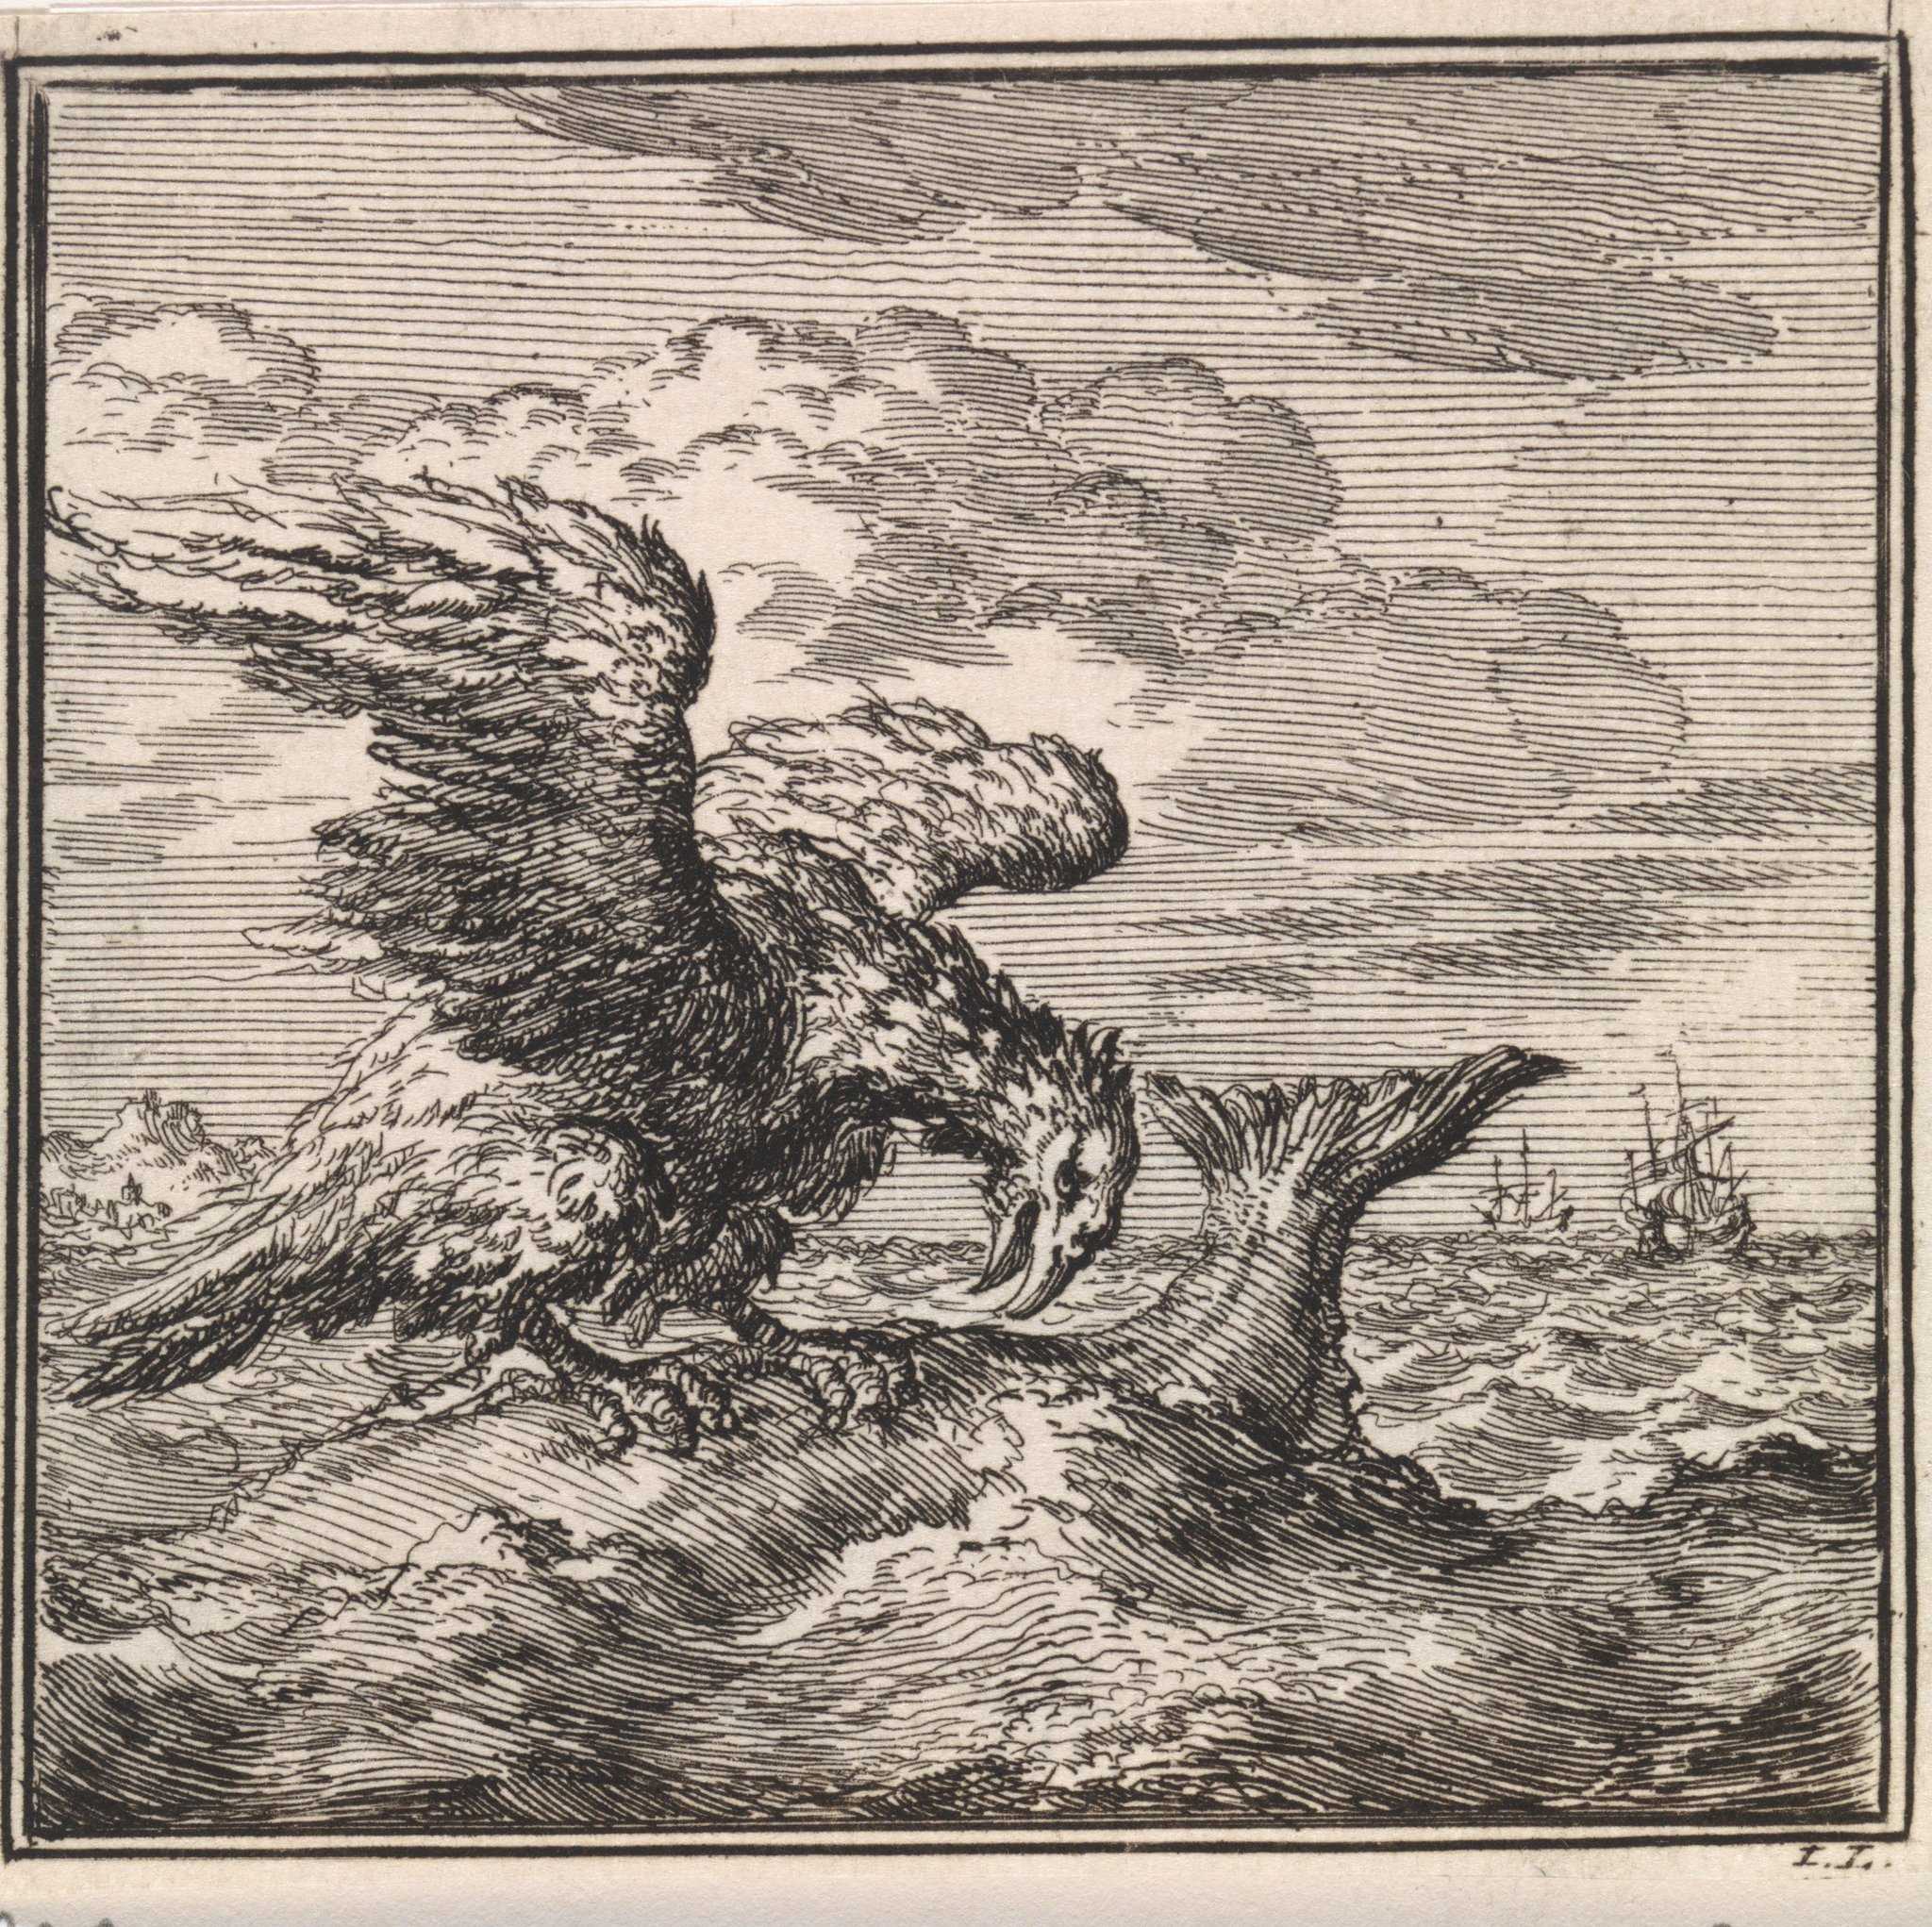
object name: print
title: Adelaar heeft zijn klauwen in de rug van een grote vis geslagen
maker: jan luyken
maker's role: draughtsman, print maker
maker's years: 1649-1712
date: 1711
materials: paper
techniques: etching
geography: amsterdam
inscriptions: collector's mark: Lugt 2228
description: Illustratie voor: Luyken, Jan. De Bykorf des Gemoeds. Amsterdam: Pieter Arentsz. II (wed.) en Cornelis van der Sys, 1711, p. 146.